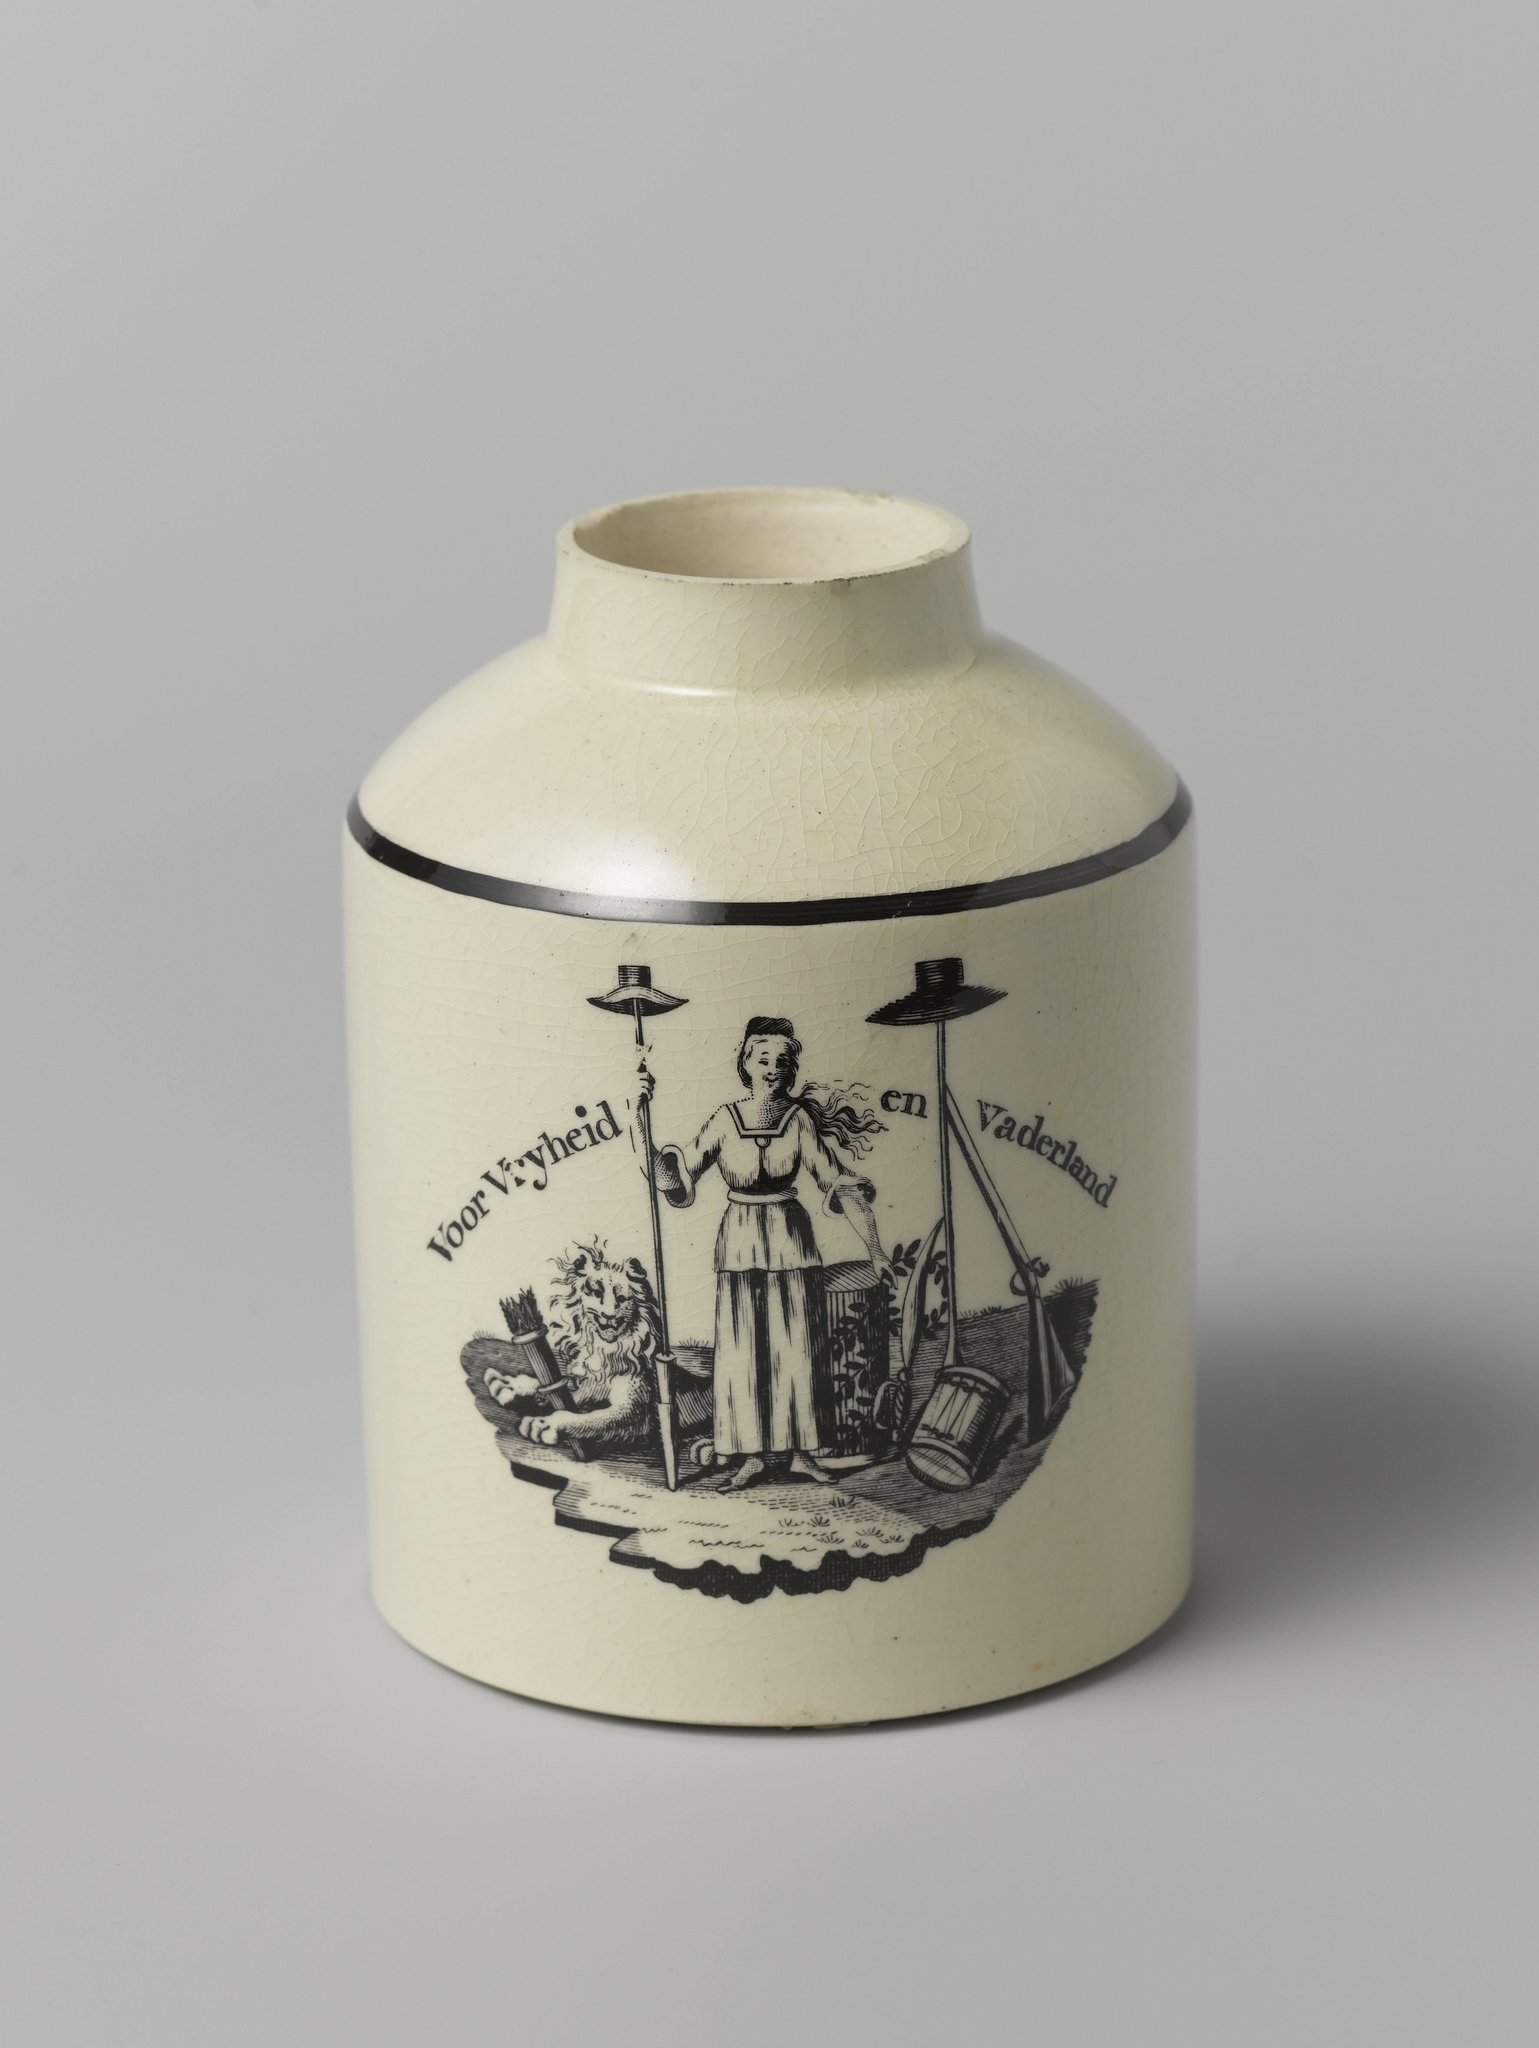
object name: tea caddy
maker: Anonymous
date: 1785-1795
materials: earthenware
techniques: transfer decoration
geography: leeds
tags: freedom, liberty; 'libertà' (ripa), symbols of particular nations, states, districts, etc.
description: Cilindrische theebus van hardgebakken aardewerk, met een transfer onder de glazuur. De bovenkant van de bus is gewelfd en heeft een smalle, korte cilindrische hals. Het deksel ontbreekt. De transfer heeft in zwart de voorstelling van de vrijheidsmaagd met attributen en het opschrift "Voor Vrijheid en Vaderland".